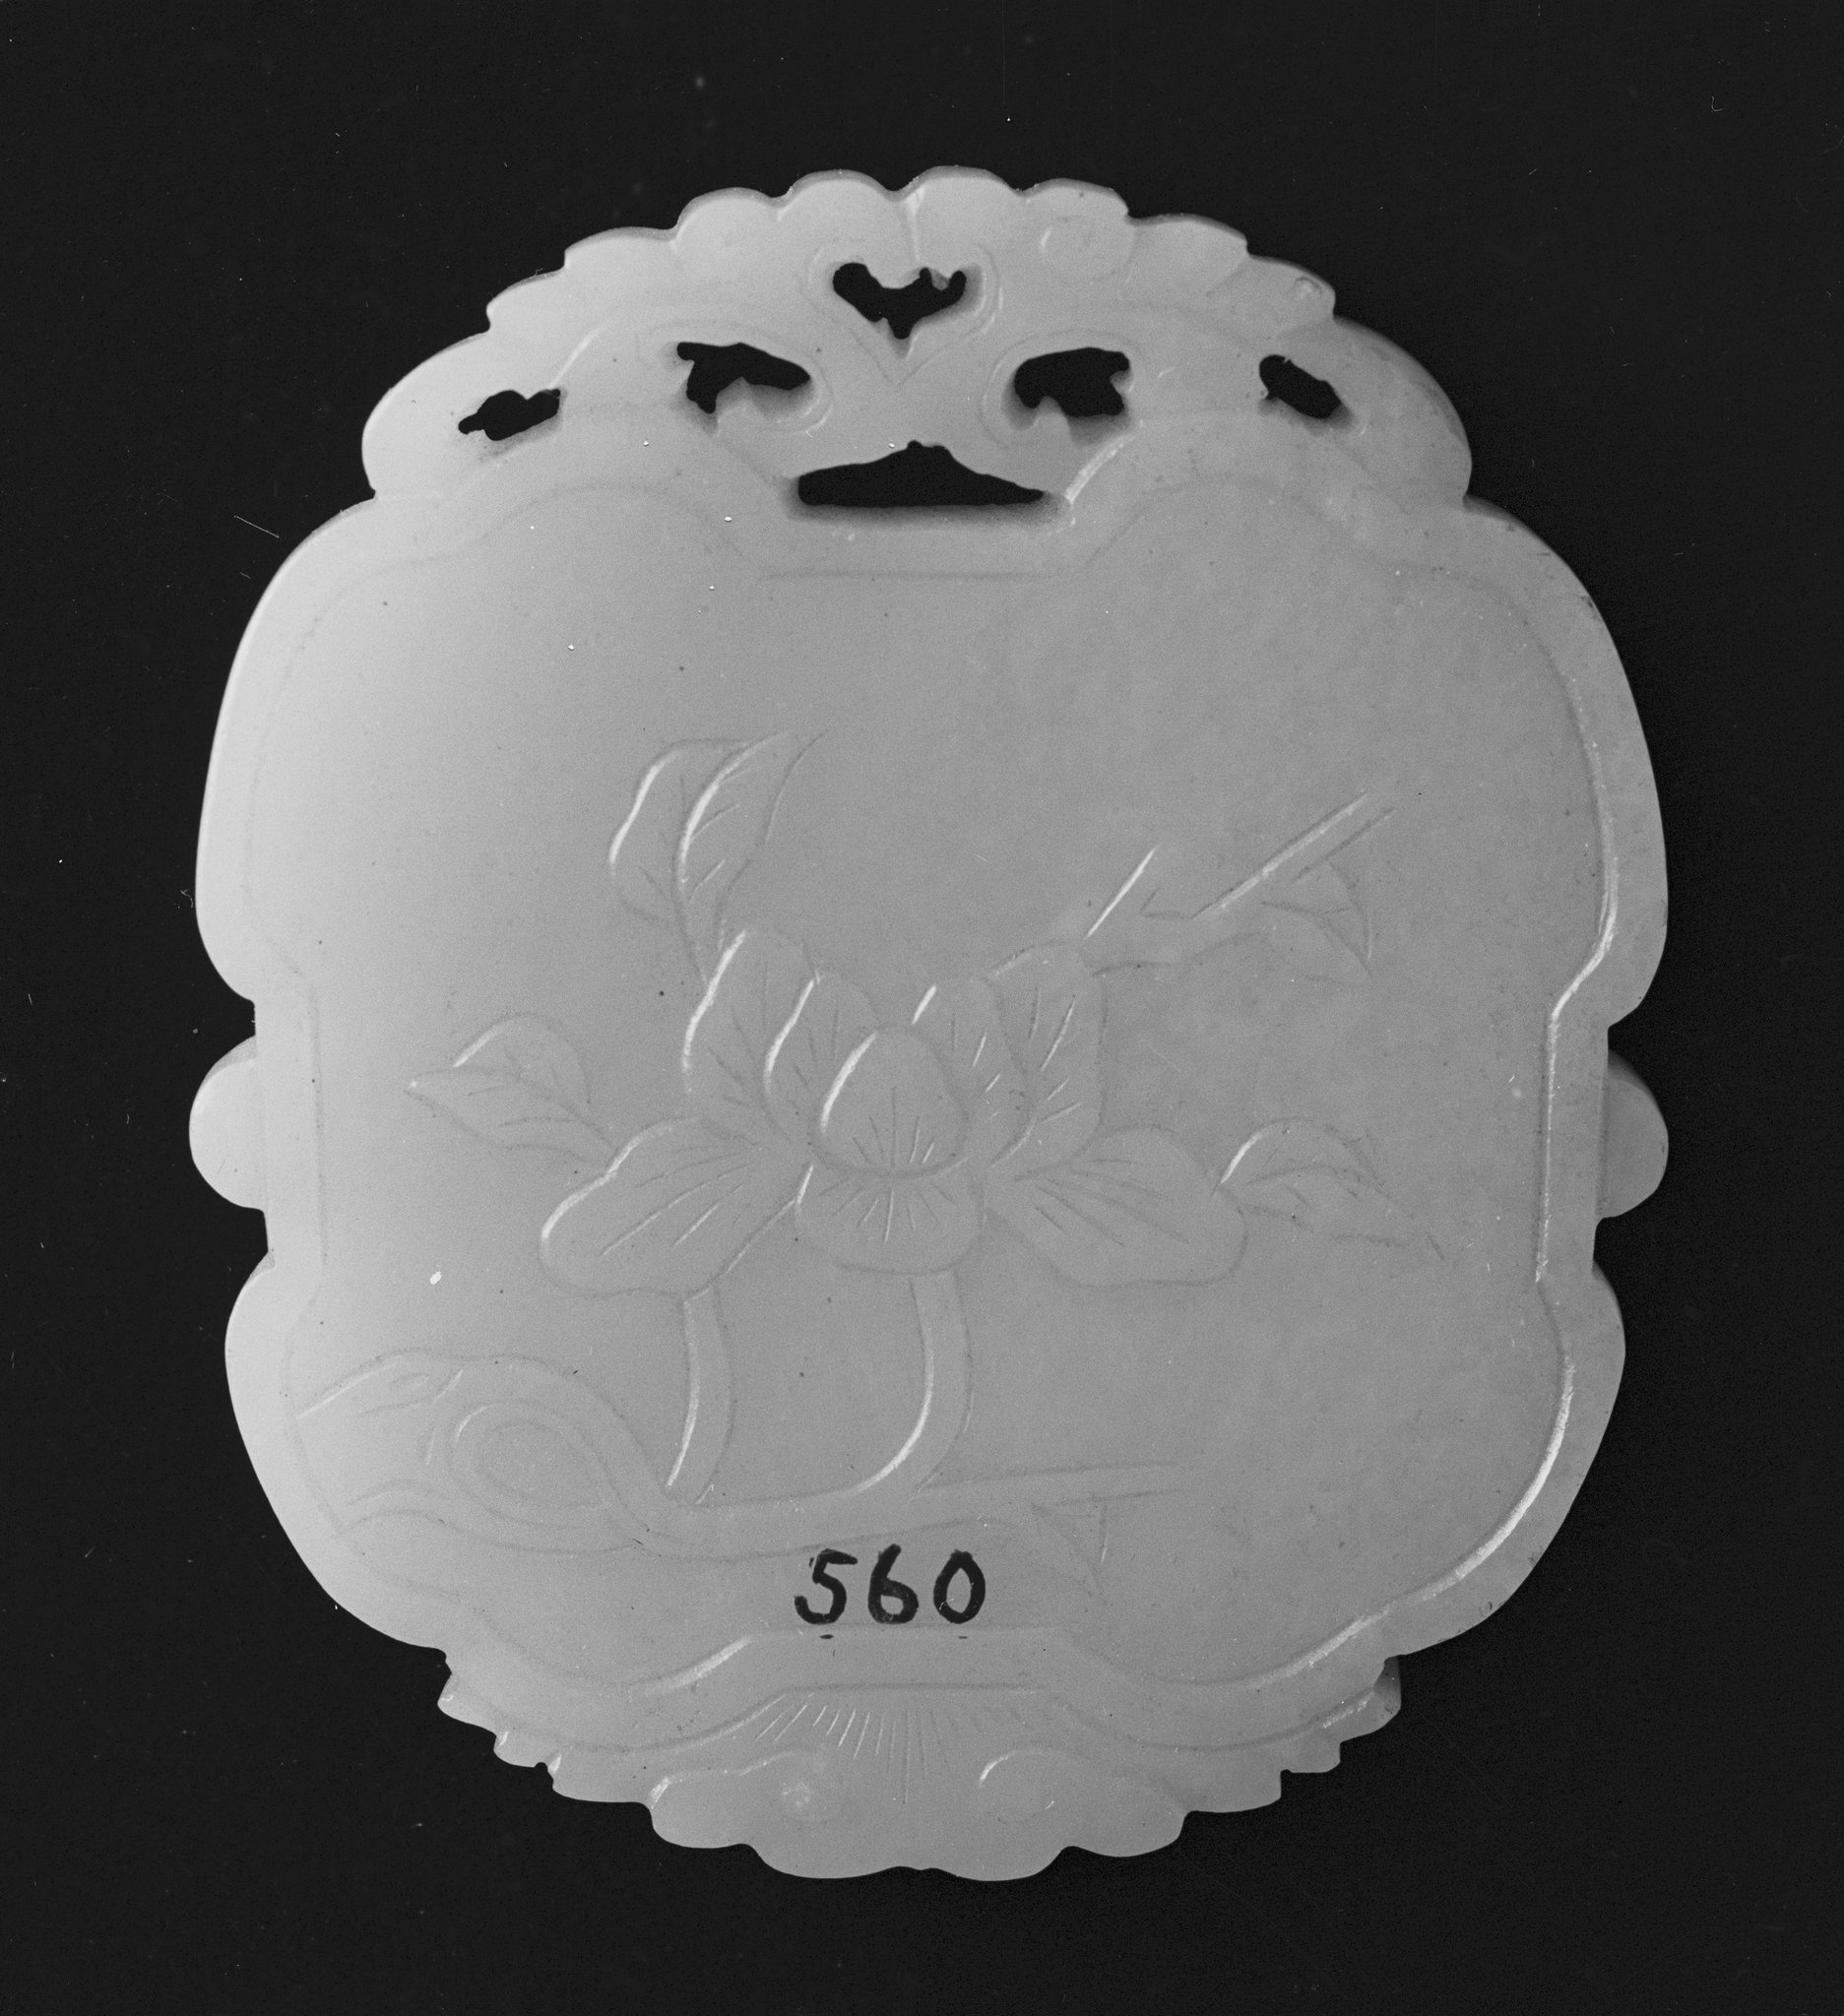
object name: medallion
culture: chinese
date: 1736-1795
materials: jade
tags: lotuses